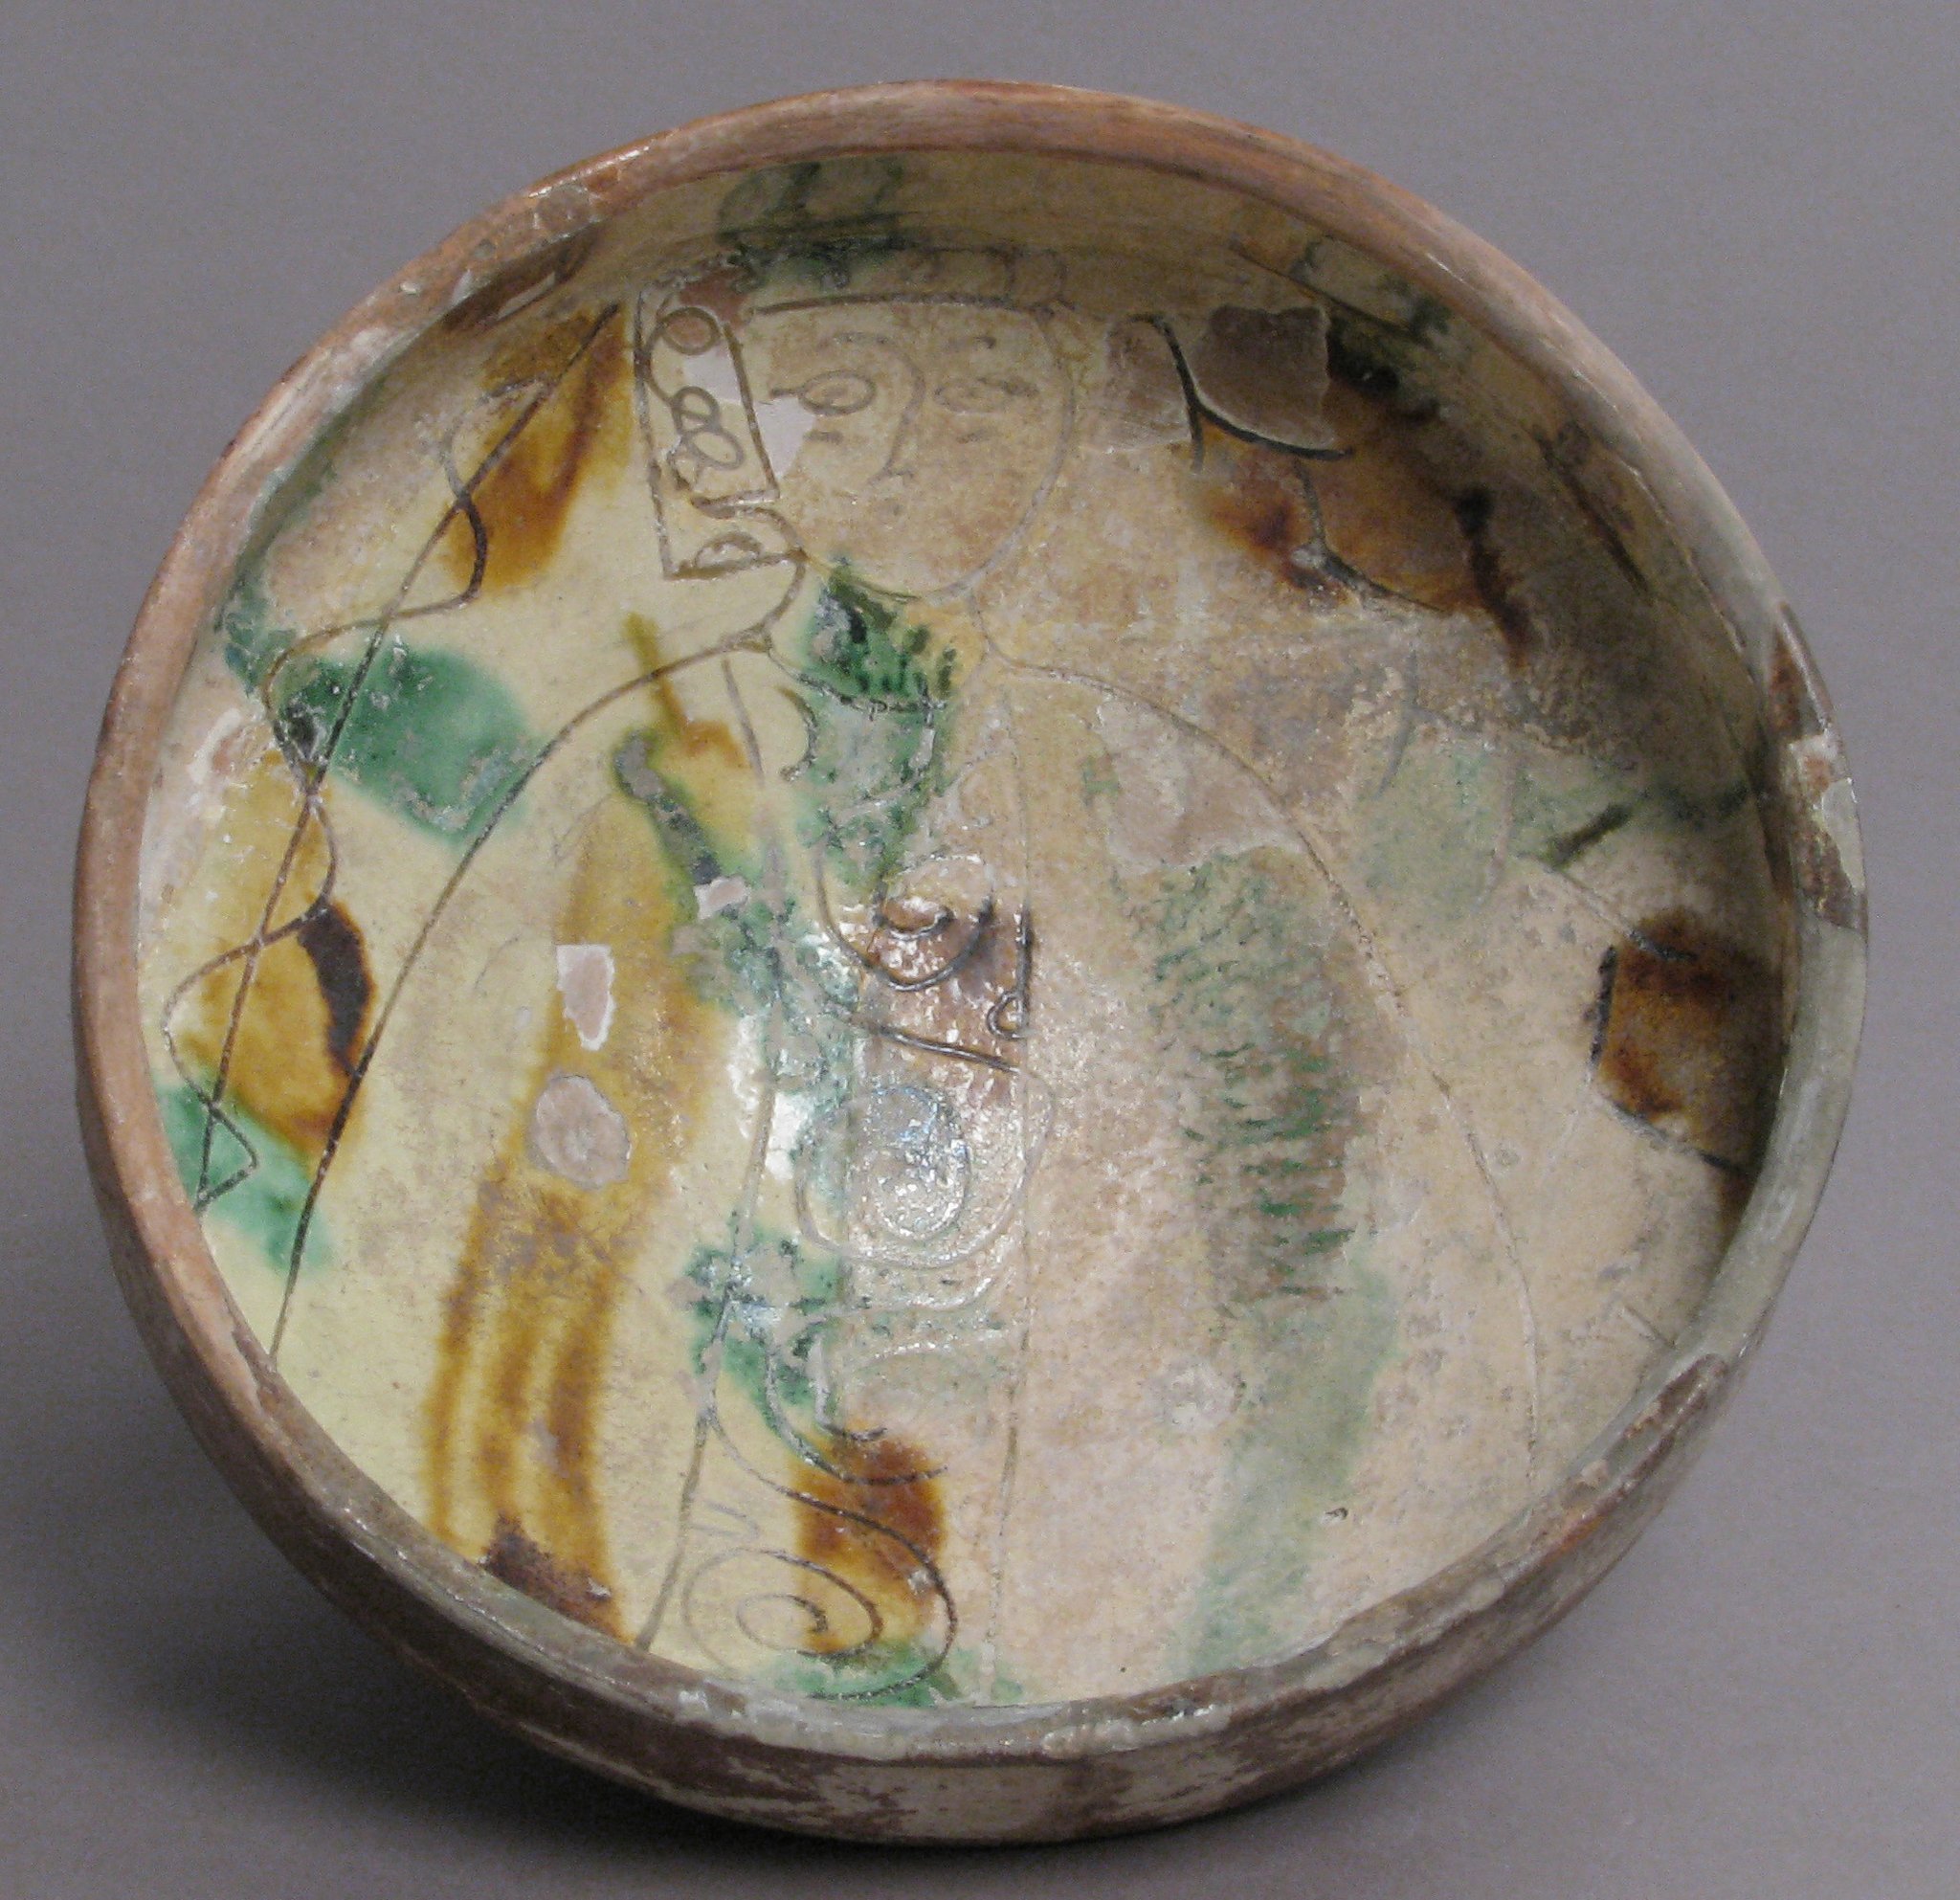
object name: bowl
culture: byzantine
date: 901-1200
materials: earthenware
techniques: glazing, maiolica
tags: human figures